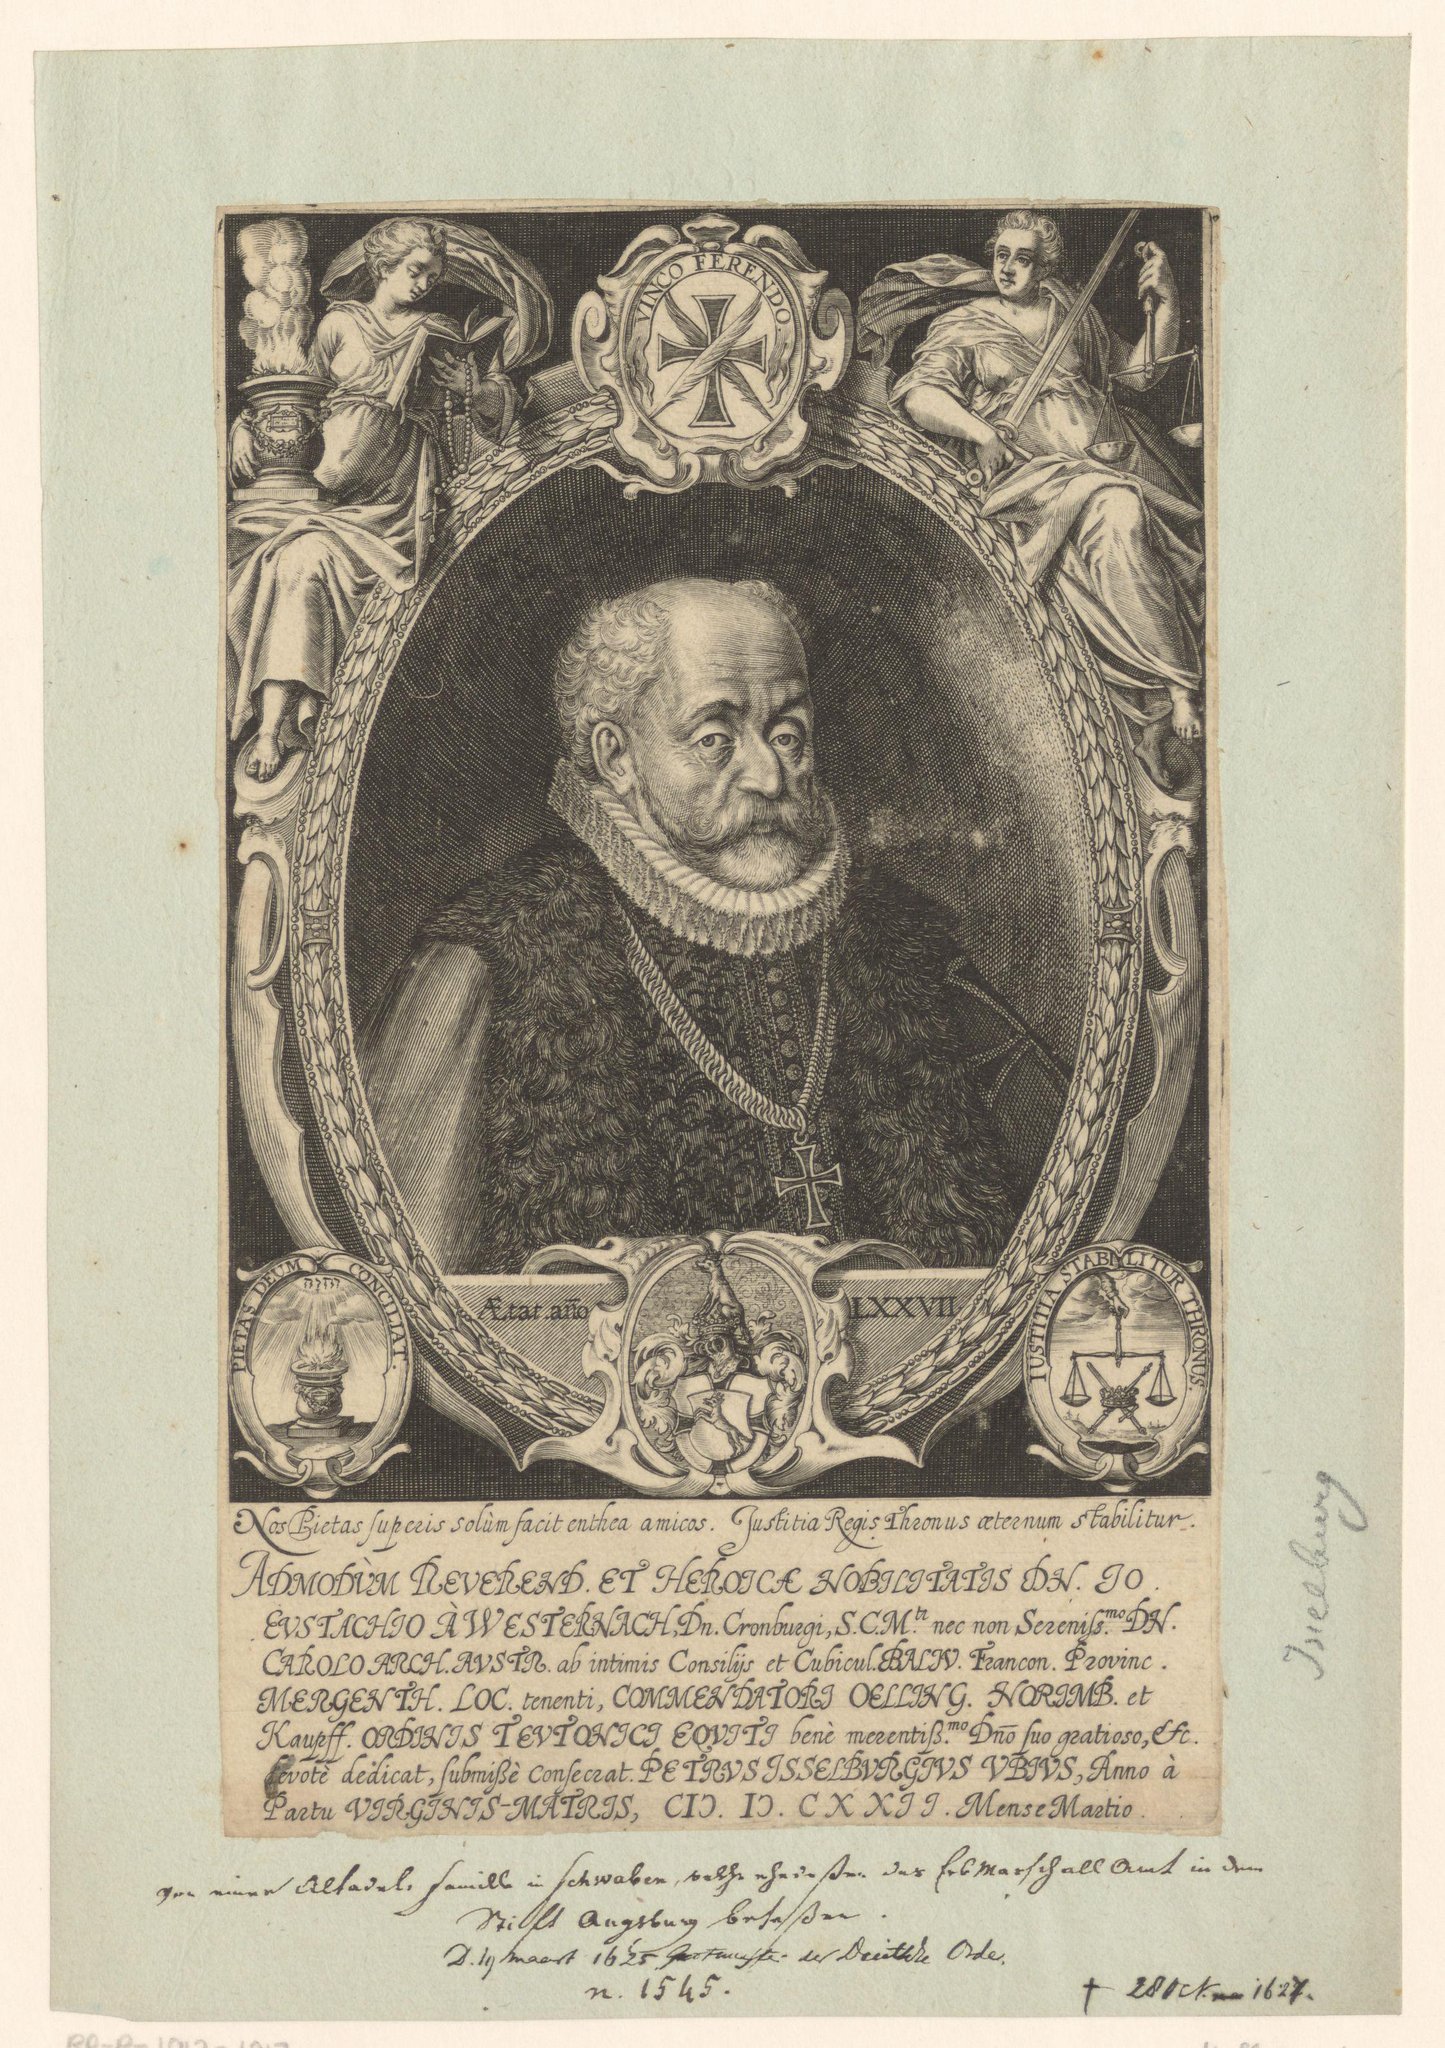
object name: print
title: Portret van Johann Eustach von Westernach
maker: peter isselburg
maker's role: print maker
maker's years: 1568-1630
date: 1578-1630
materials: paper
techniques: engraving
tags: bad mergentheim, politician, historical persons, politician, e.g. party leader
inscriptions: collector's mark: Lugt 2228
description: Bovenop het medaillon twee personificaties van Rechtvaardigheid en Vroomheid. Tekst in het Latijn in de marge.